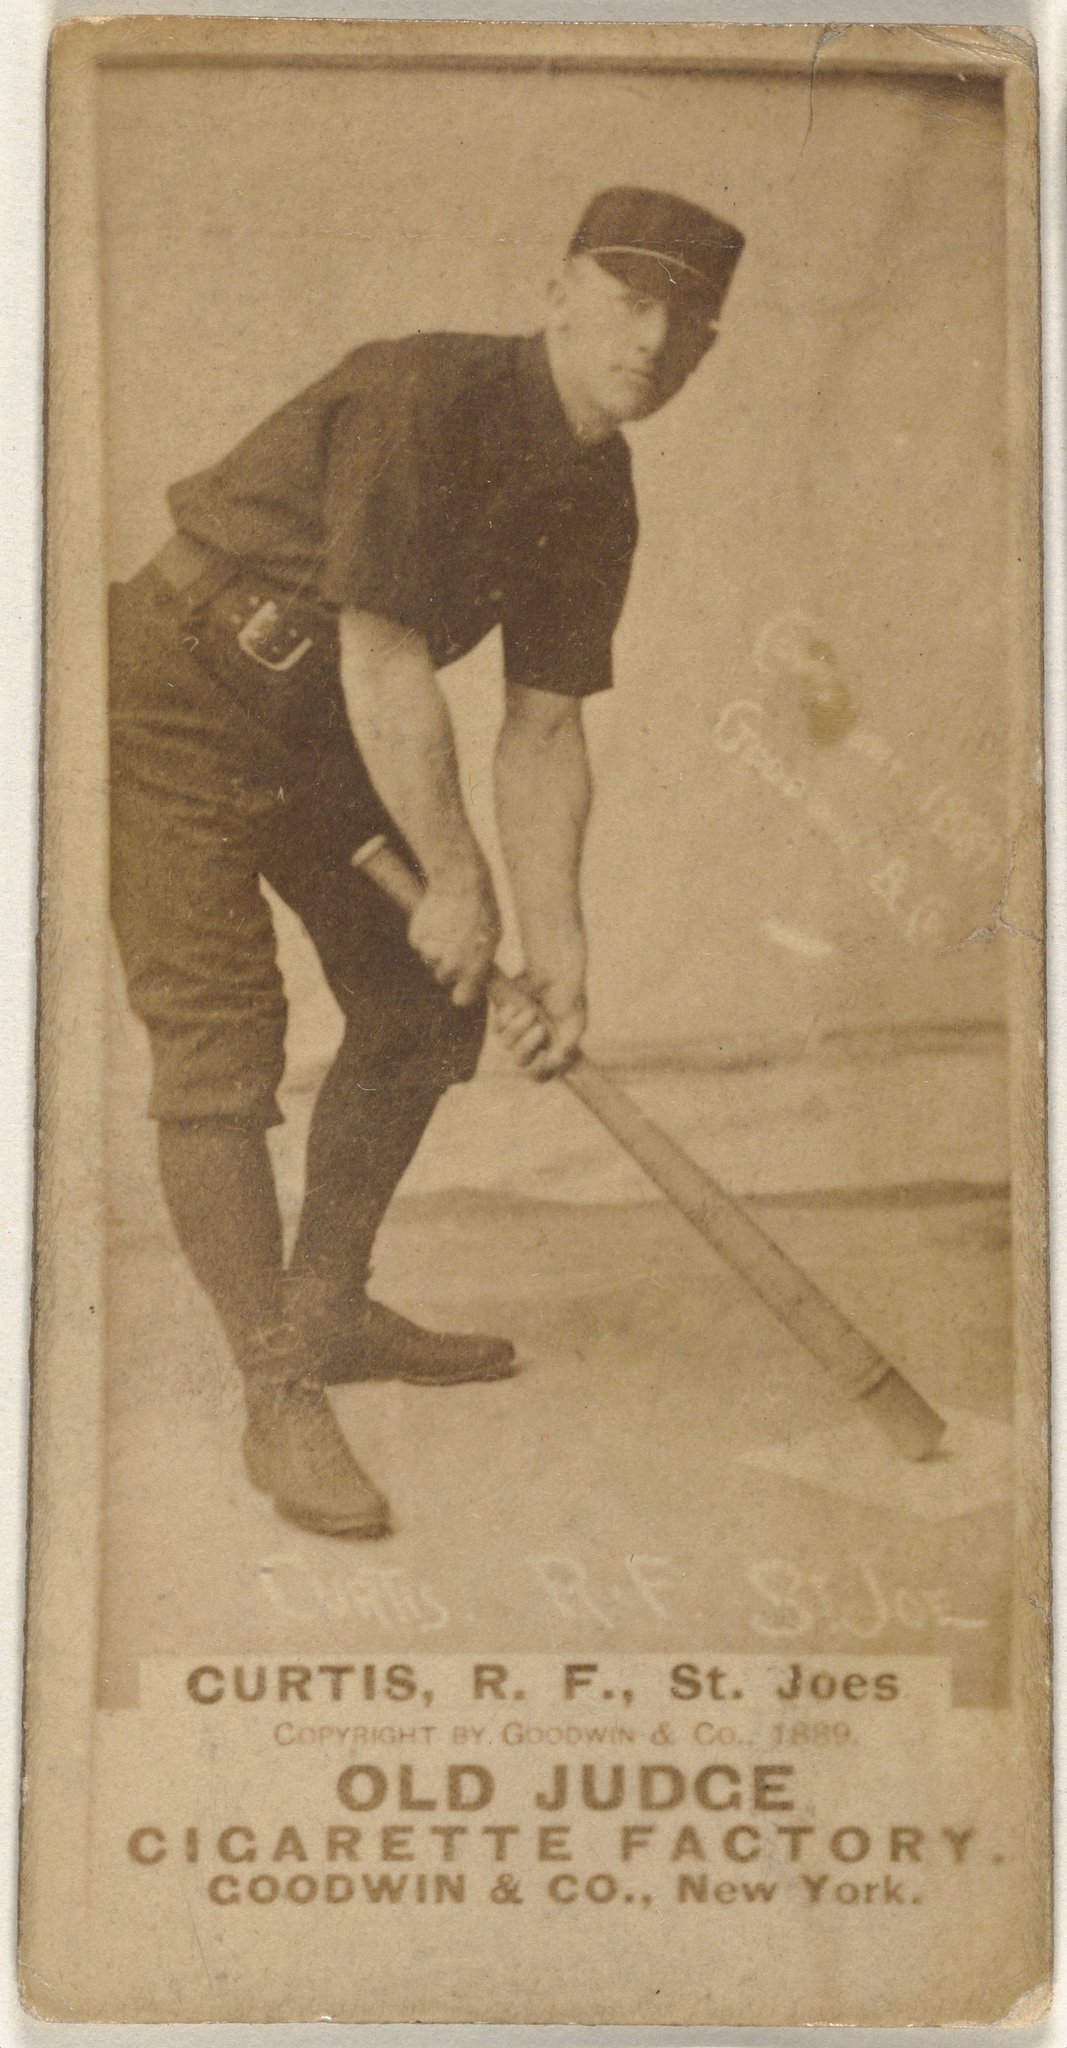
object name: baseball card, photograph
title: Ervin Duane "Jim" Curtiss, Right Field, St. Joseph Clay Eaters, from the Old Judge series (N172) for Old Judge Cigarettes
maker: goodwin & company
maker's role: publisher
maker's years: 1850-1950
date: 1889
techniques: albumen silver print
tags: men,portraits,baseball,athletes